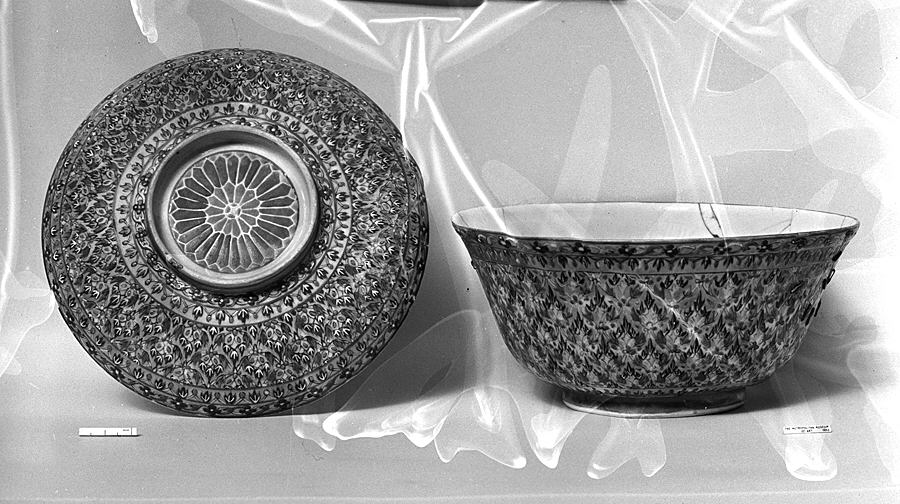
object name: covered bowl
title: Covered bowl with floral patterns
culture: chinese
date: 1801-1900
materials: enamel, porcelain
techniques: overglaze, painting, polychrome